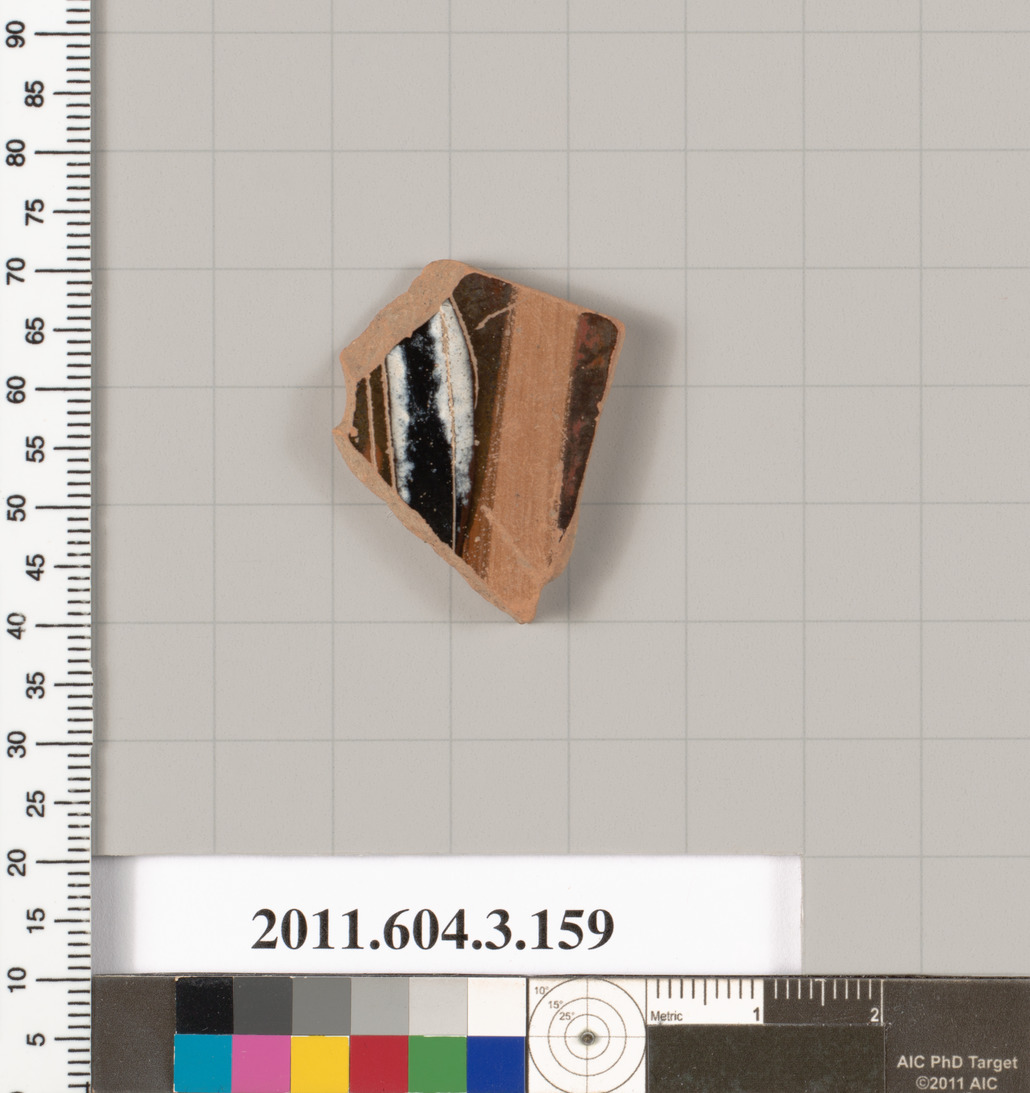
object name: amphora fragment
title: Terracotta fragment of an amphora (jar)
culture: greek, attic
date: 550-540 BCE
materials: terracotta